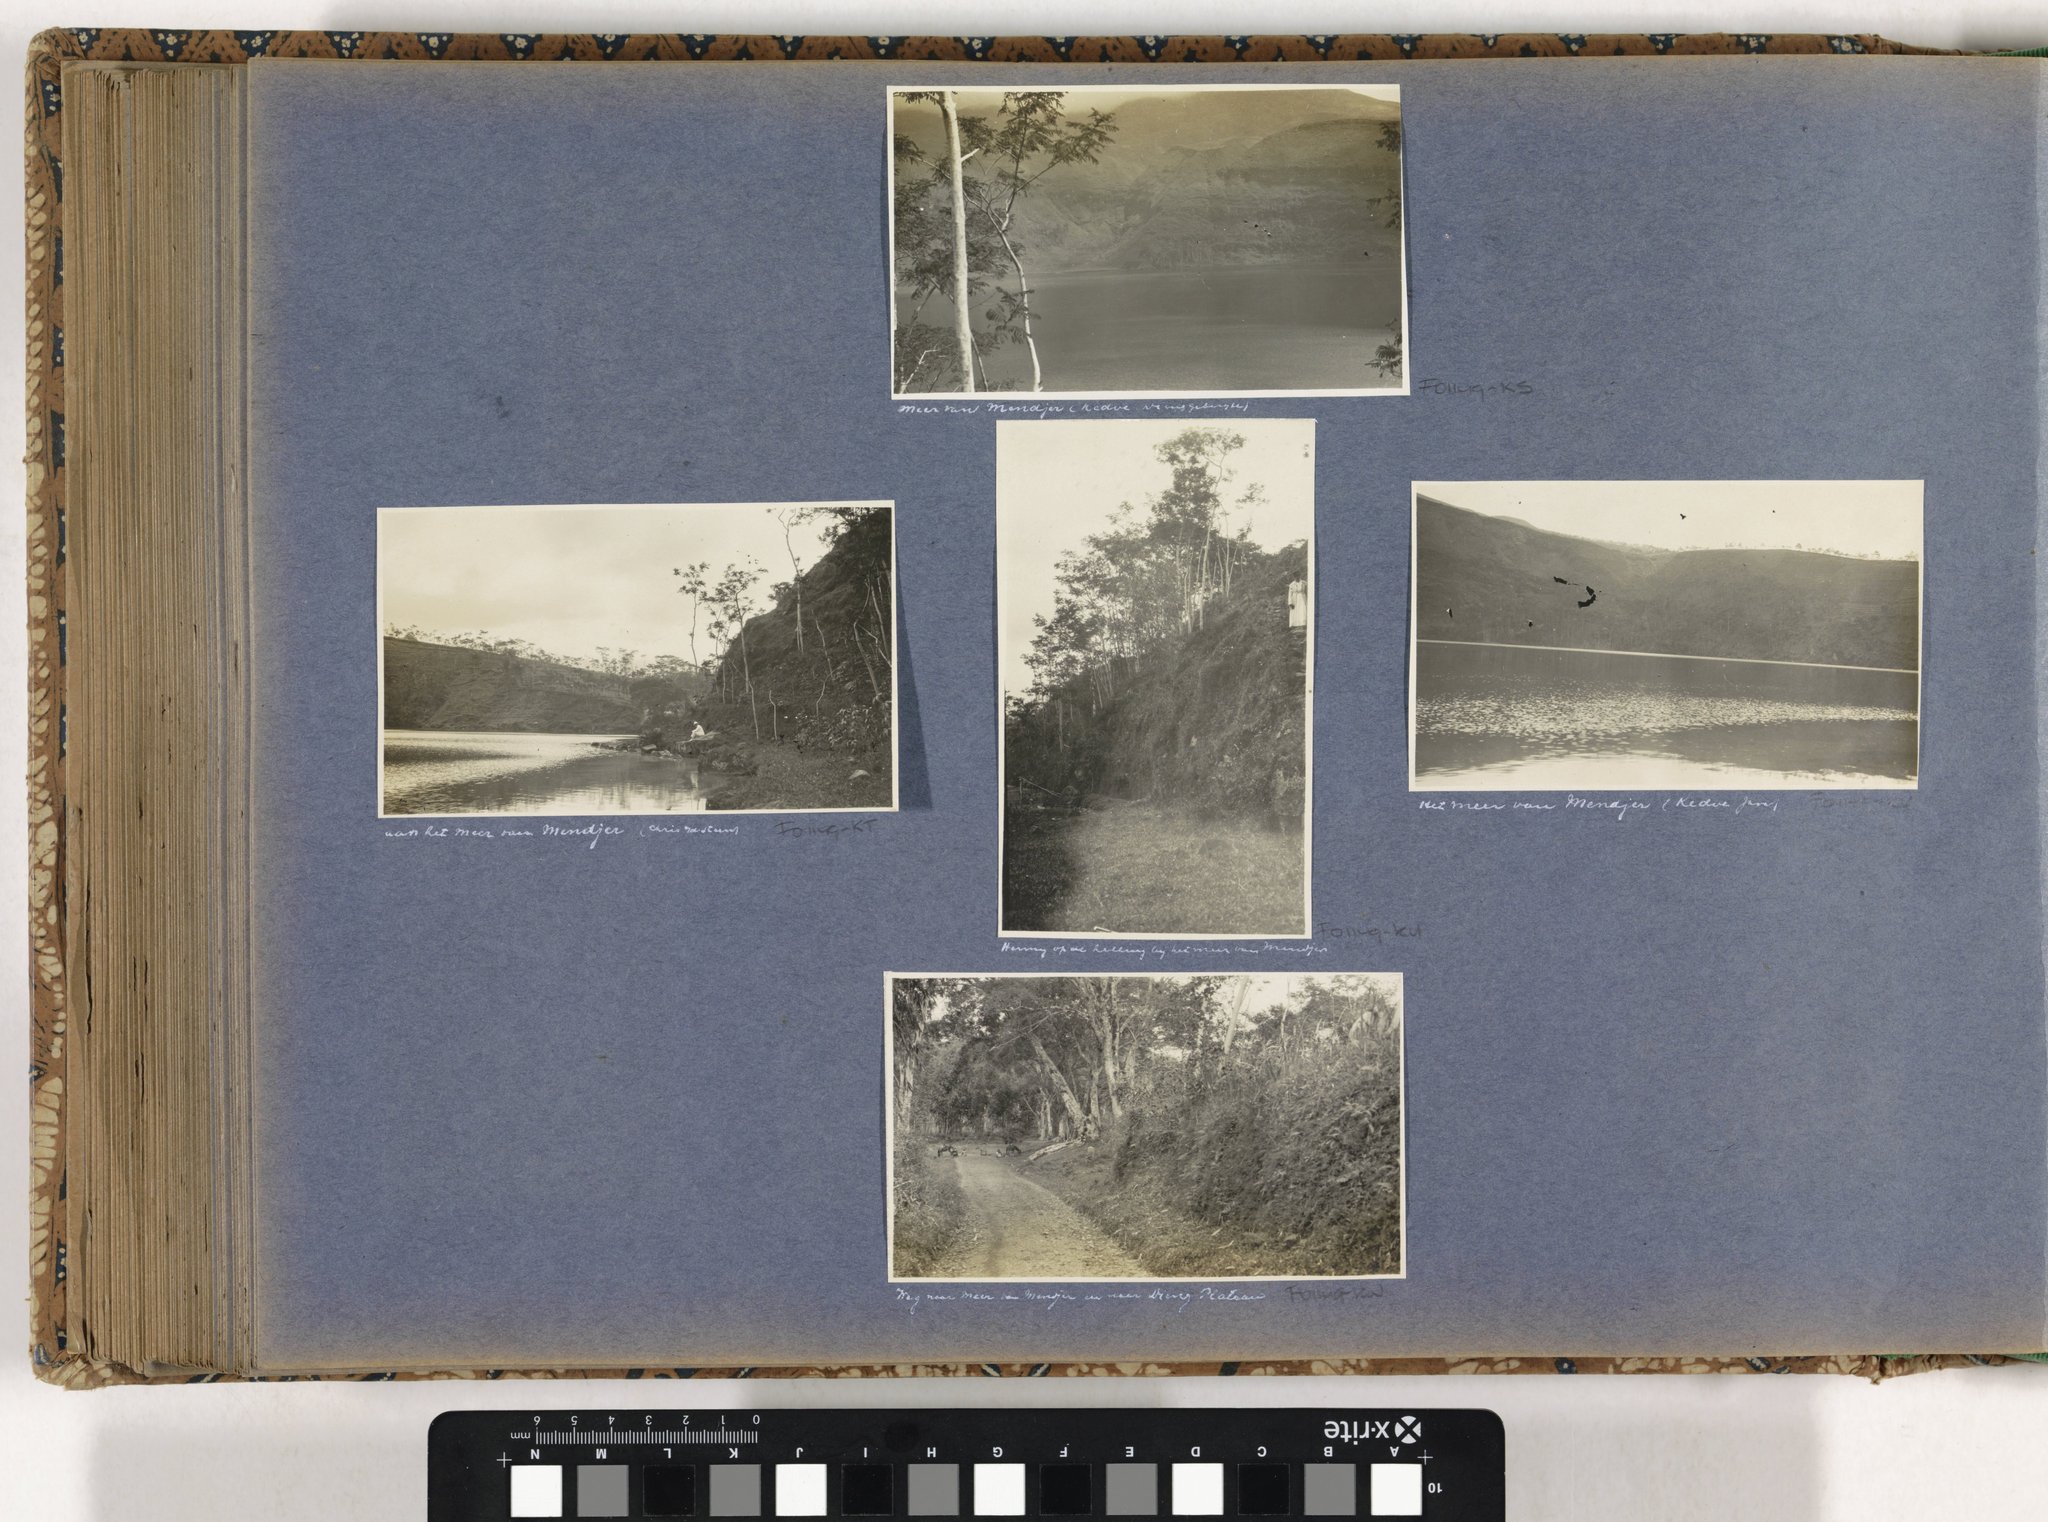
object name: photograph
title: Weg naar het Meer van Mindjer met rustende Indische dragers en paarden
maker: Anonymous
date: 1900-1920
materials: paper, photographic support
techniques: gelatin silver print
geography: java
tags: carrying something, road, path, java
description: Onderdeel van reisalbum met foto's van bedrijvigheid en bezienswaardigheden op Sumatra en Java en van de reis naar en van Nederlands-Indië.